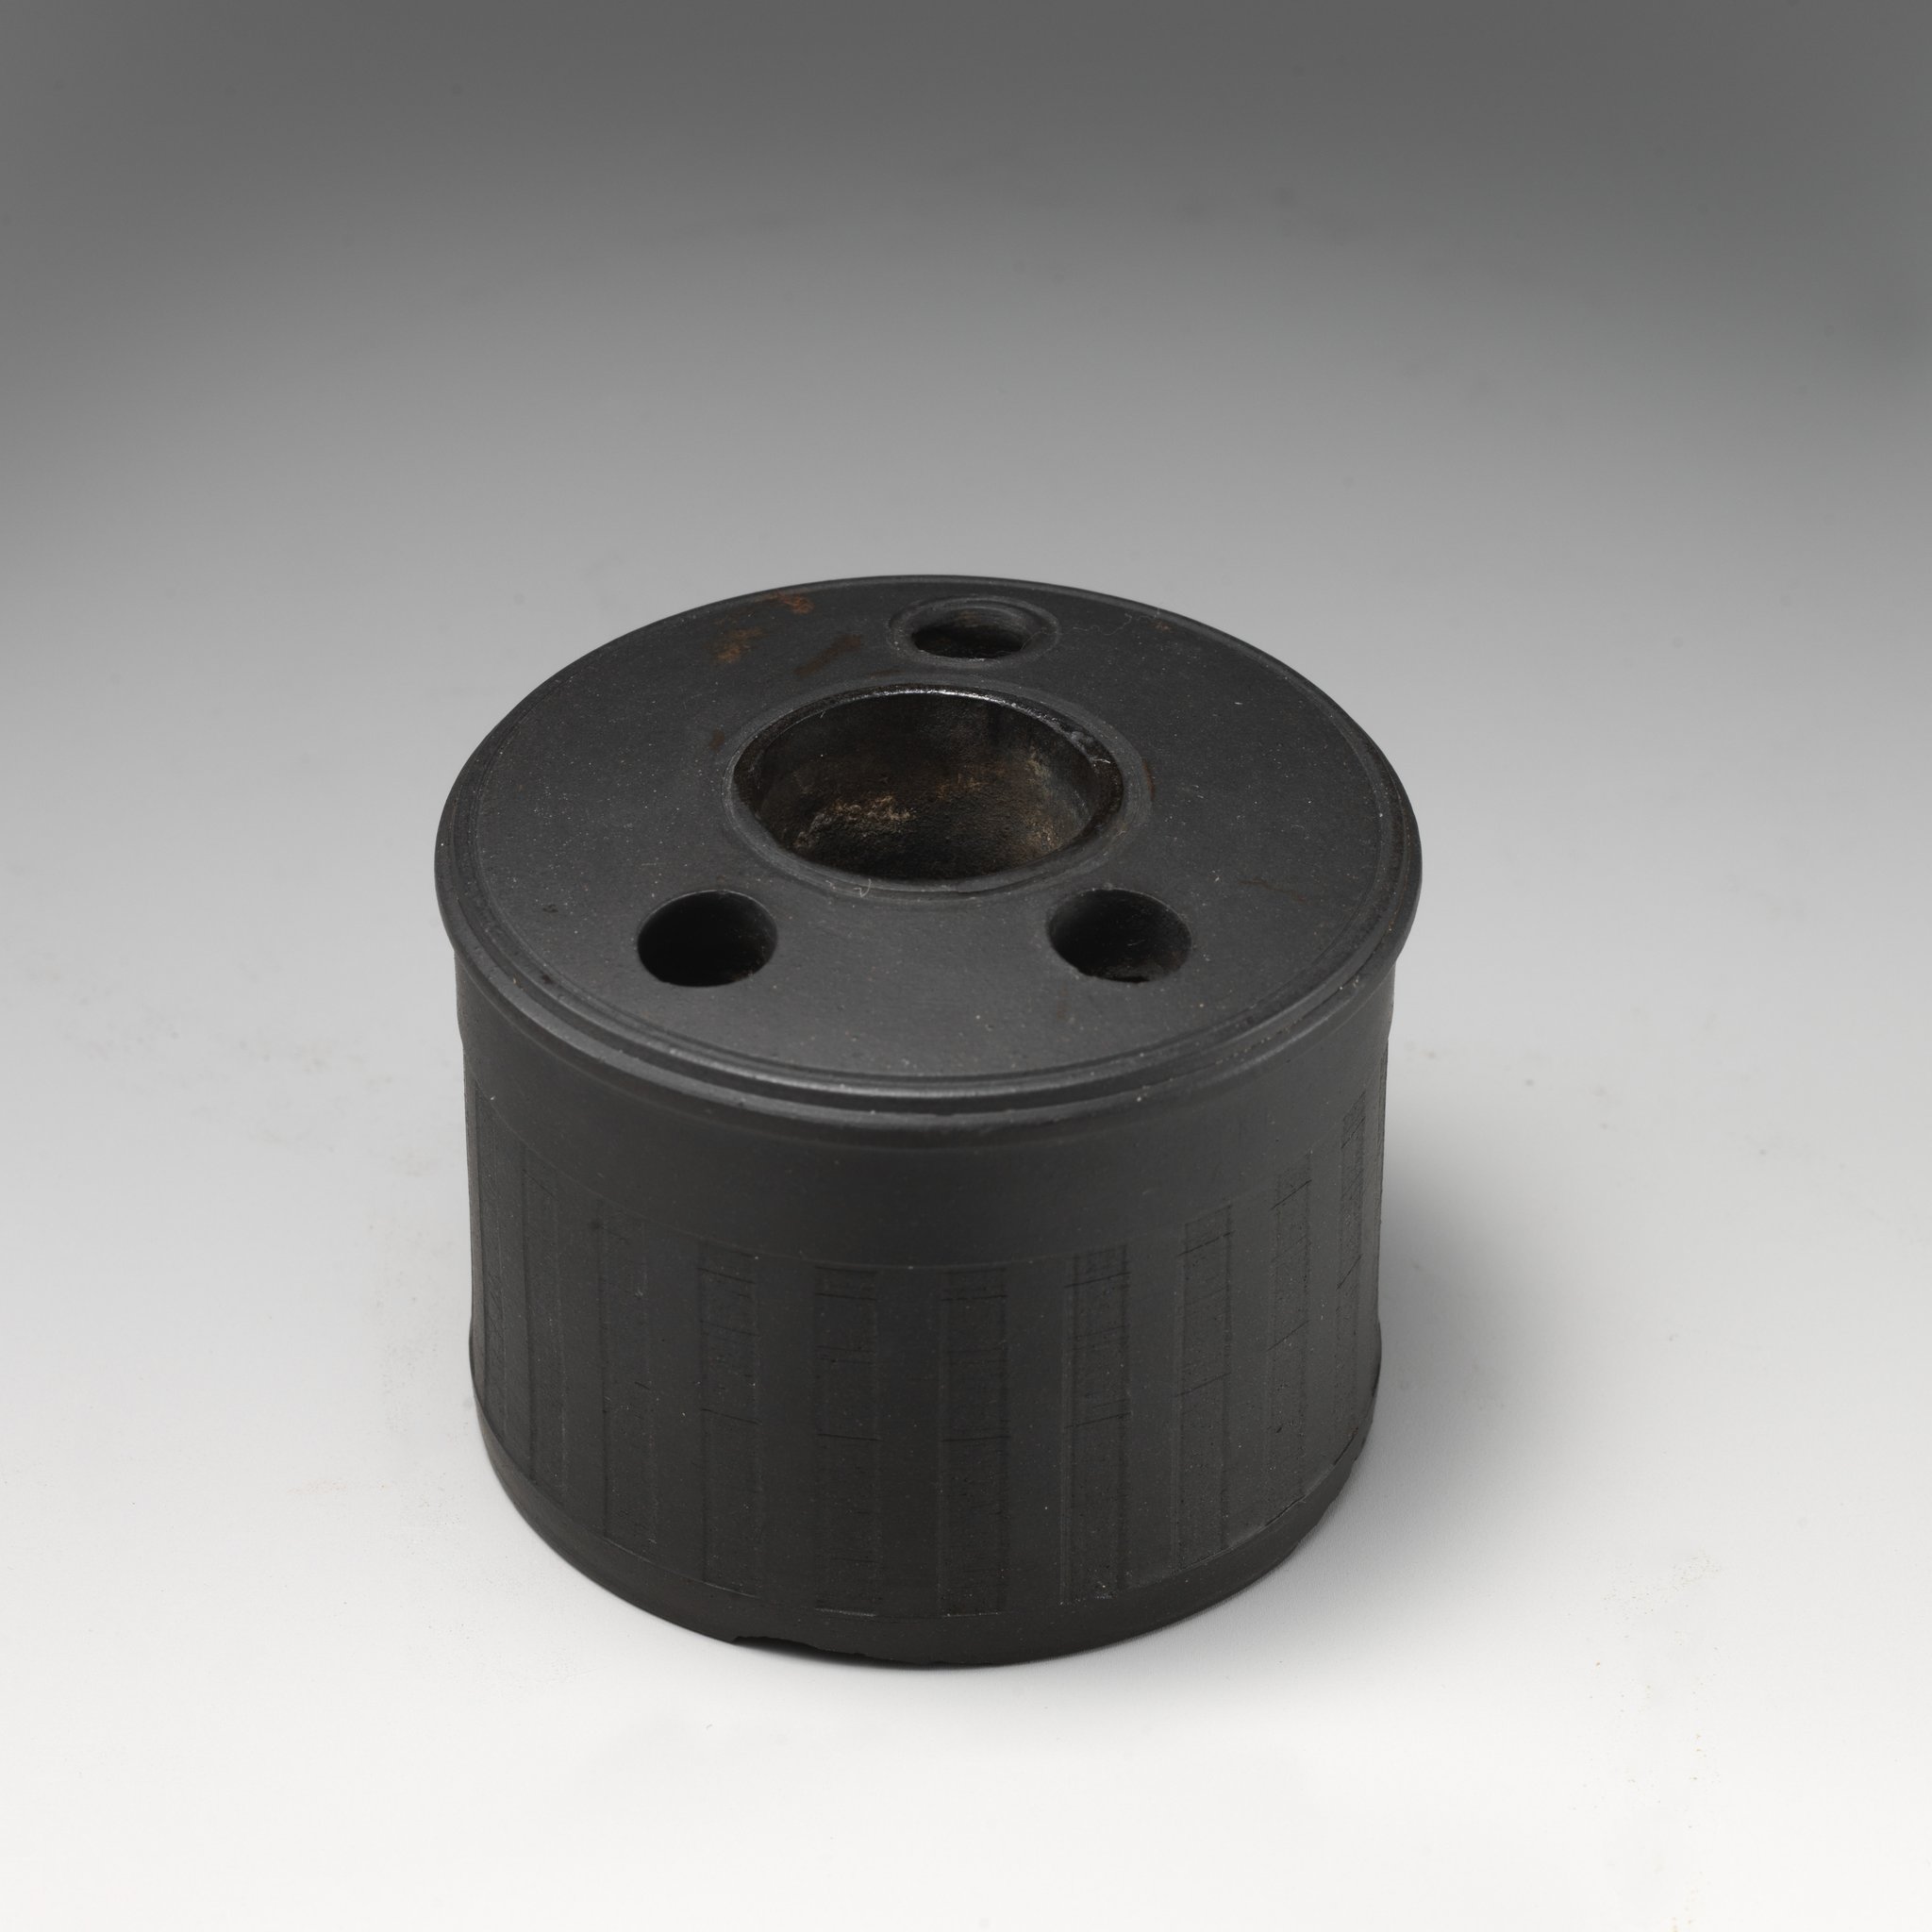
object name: inkstand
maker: wedgwood and bentley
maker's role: maker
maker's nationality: british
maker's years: 1769-1780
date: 1701-1800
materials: stone